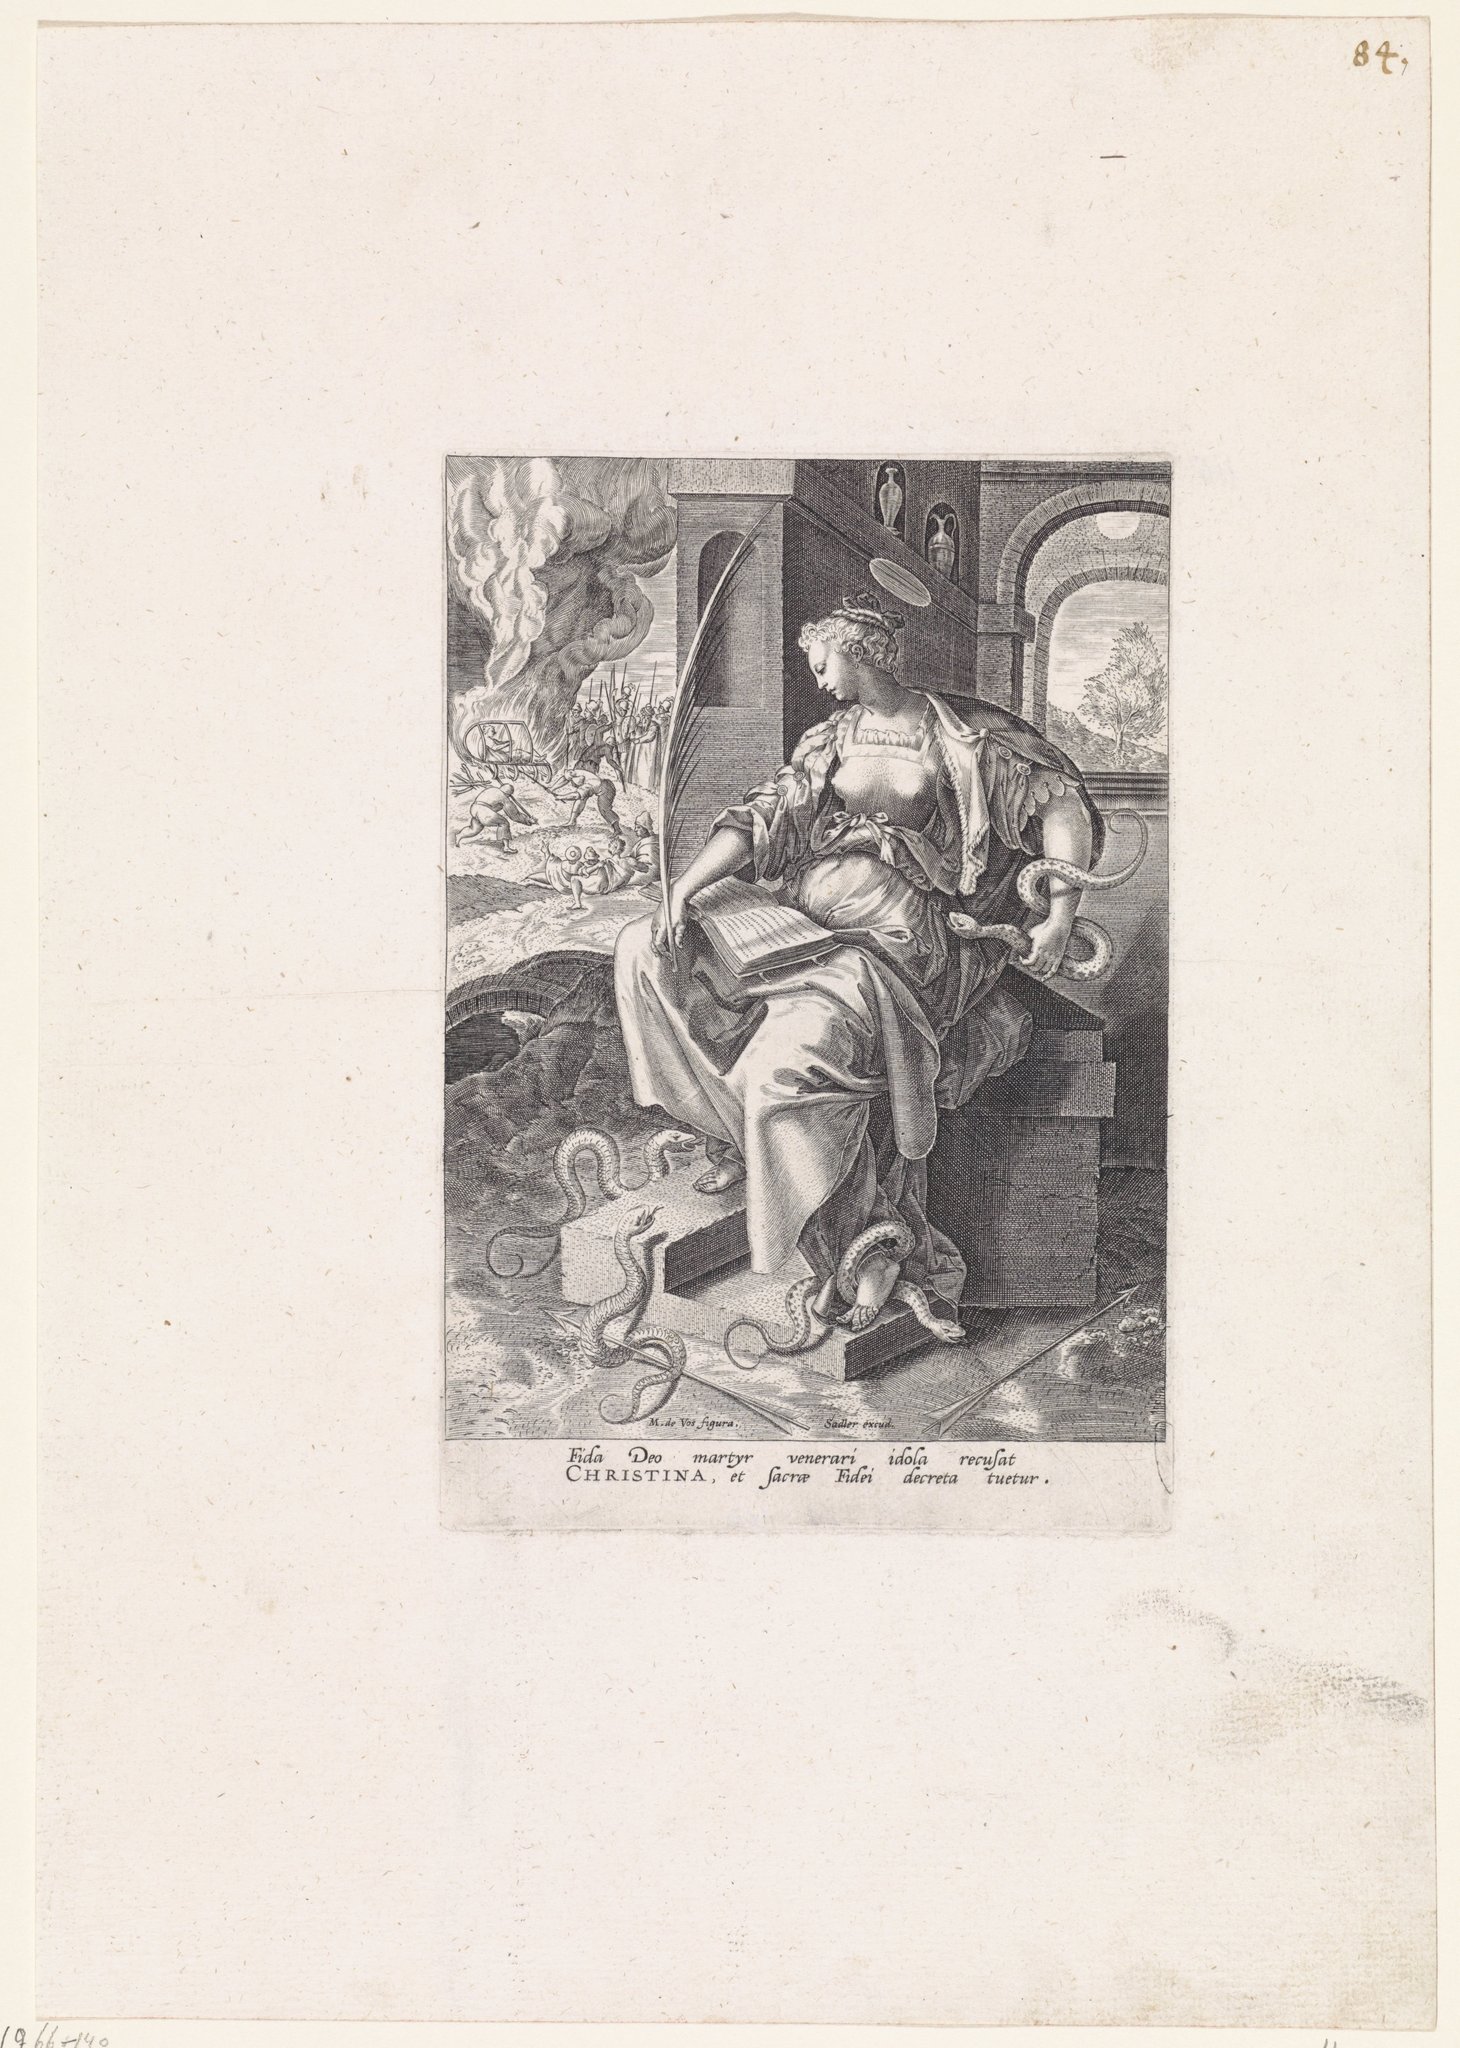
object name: print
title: Spiegel van eerbaarheid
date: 1583-1587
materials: paper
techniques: engraving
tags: female saints (christine)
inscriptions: number: ‘84’, collector's mark: Lugt 2228, collector's mark: Lugt 2760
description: De H. Christina, zittend. Ze leest een boek. In haar linkerhand een slang. Rondom haar benen drie andere slangen. Op de achtergrond wordt ze in een oven verbrand. De achtste prent van een zeventiendelige serie met vrouwelijke heiligen.